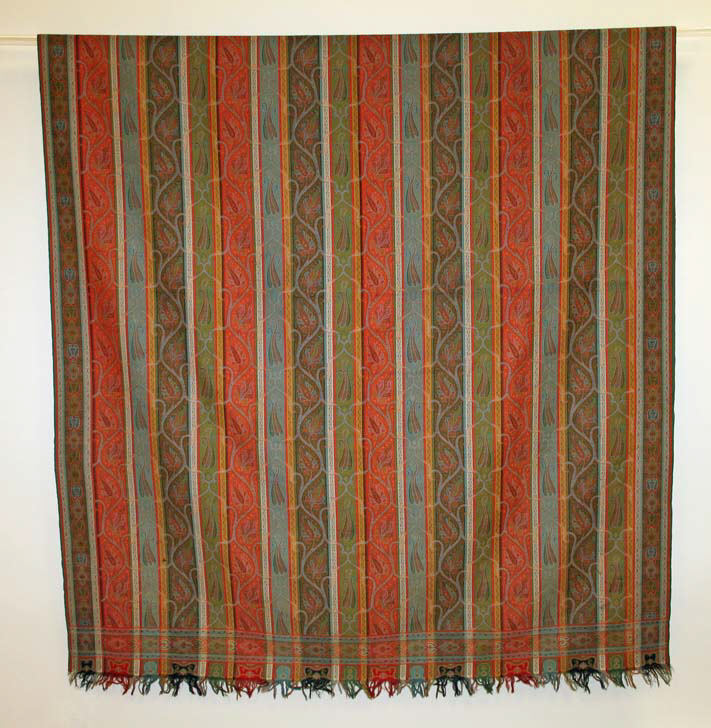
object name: shawl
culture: french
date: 1860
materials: wool